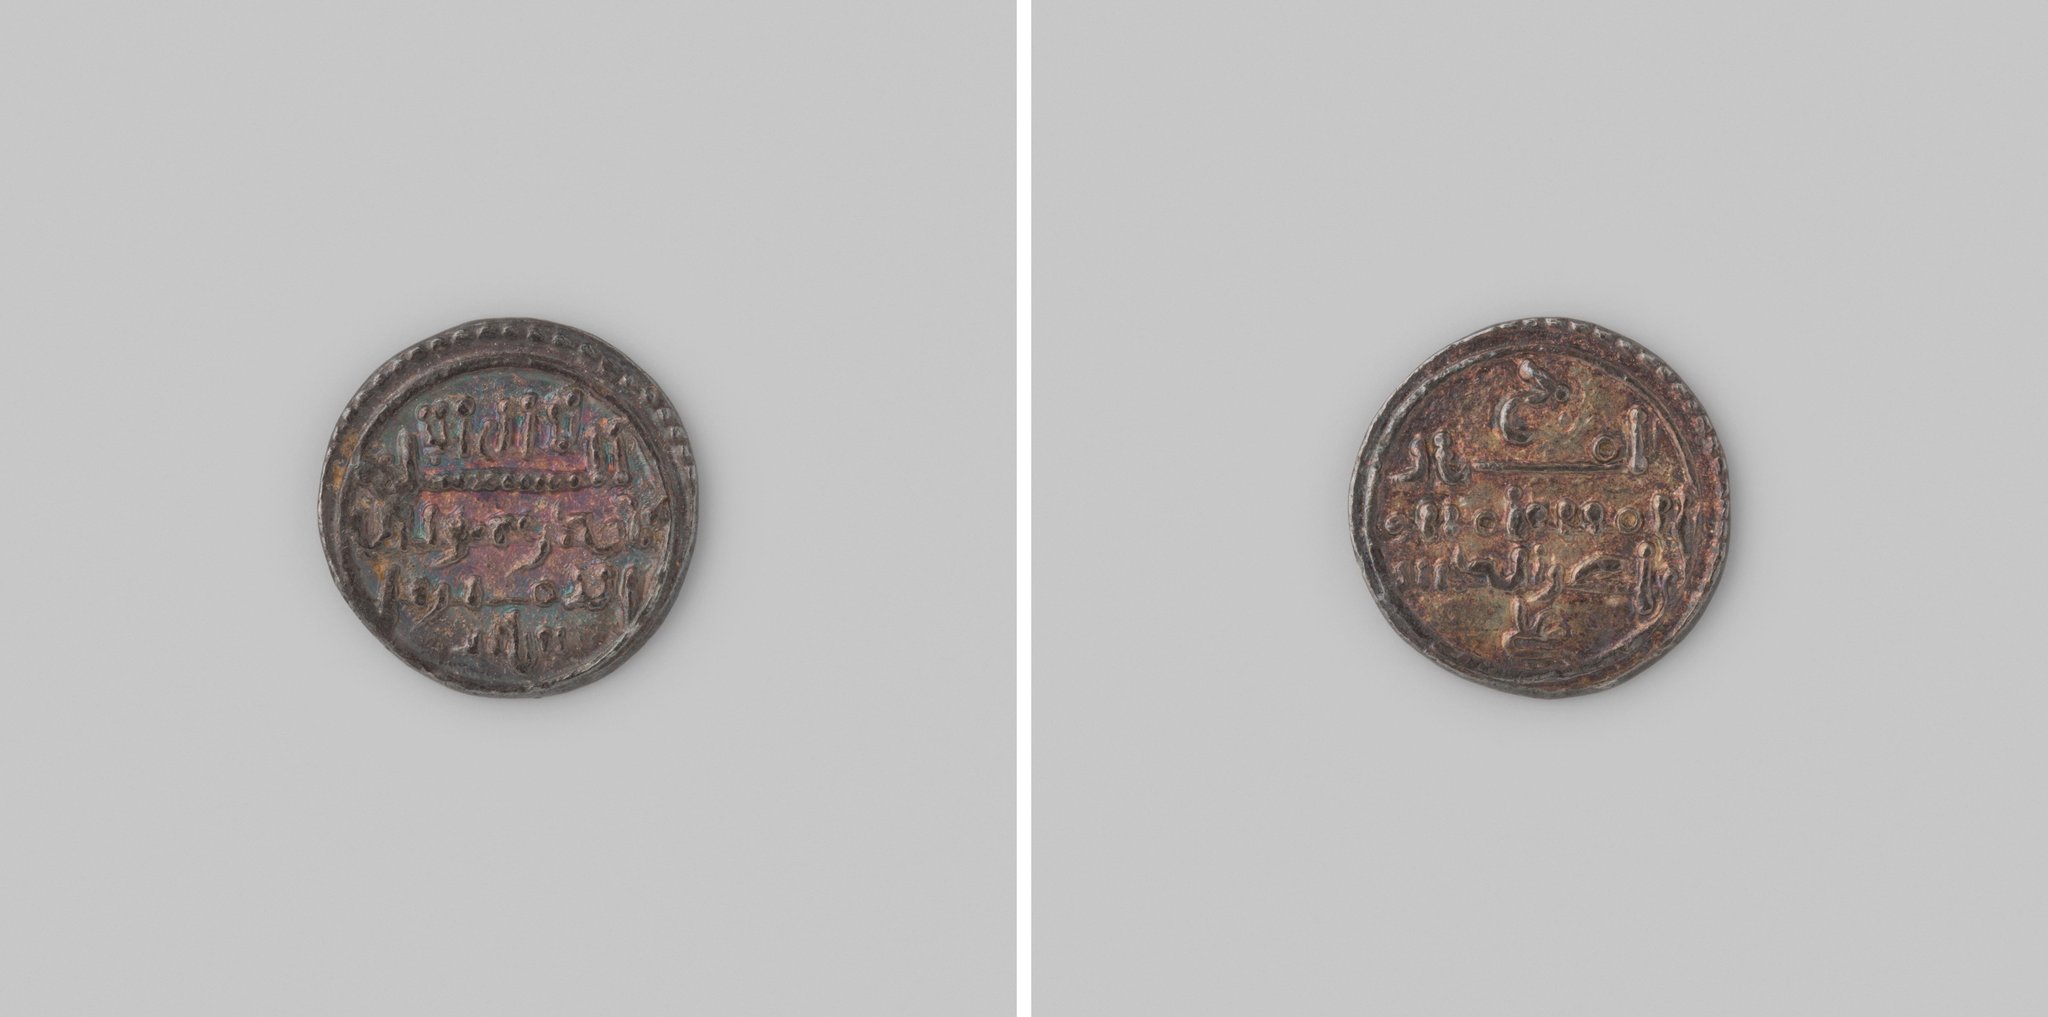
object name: coin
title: Kiraat of dirhem uit Tunesië of Marokko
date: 1100-1200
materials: silver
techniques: striking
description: Zilveren munt. Voorzijde: vijfregelig opschrift in Arabische letters. Keerzijde: vijfregelig opschrift in Arabische letters.